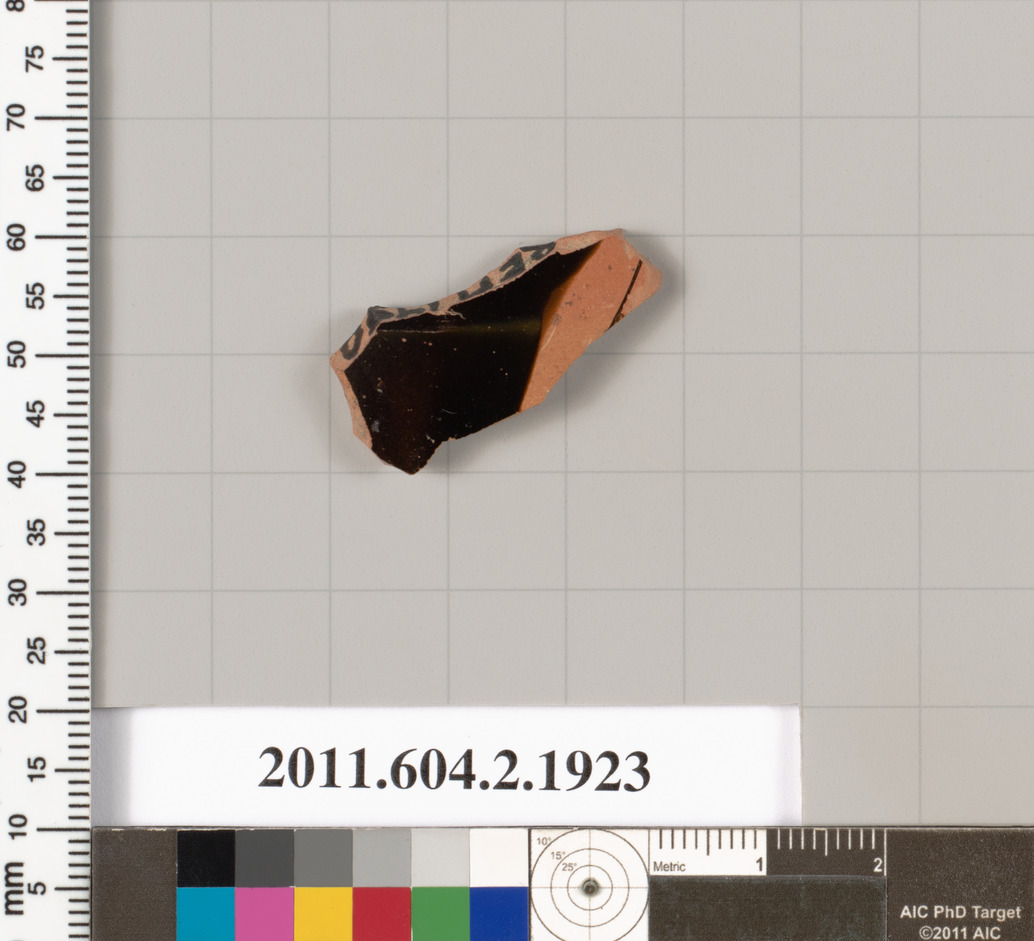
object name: skyphos fragment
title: Terracotta fragment of a skyphos (deep drinking cup)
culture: greek, attic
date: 450-401 BCE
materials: terracotta